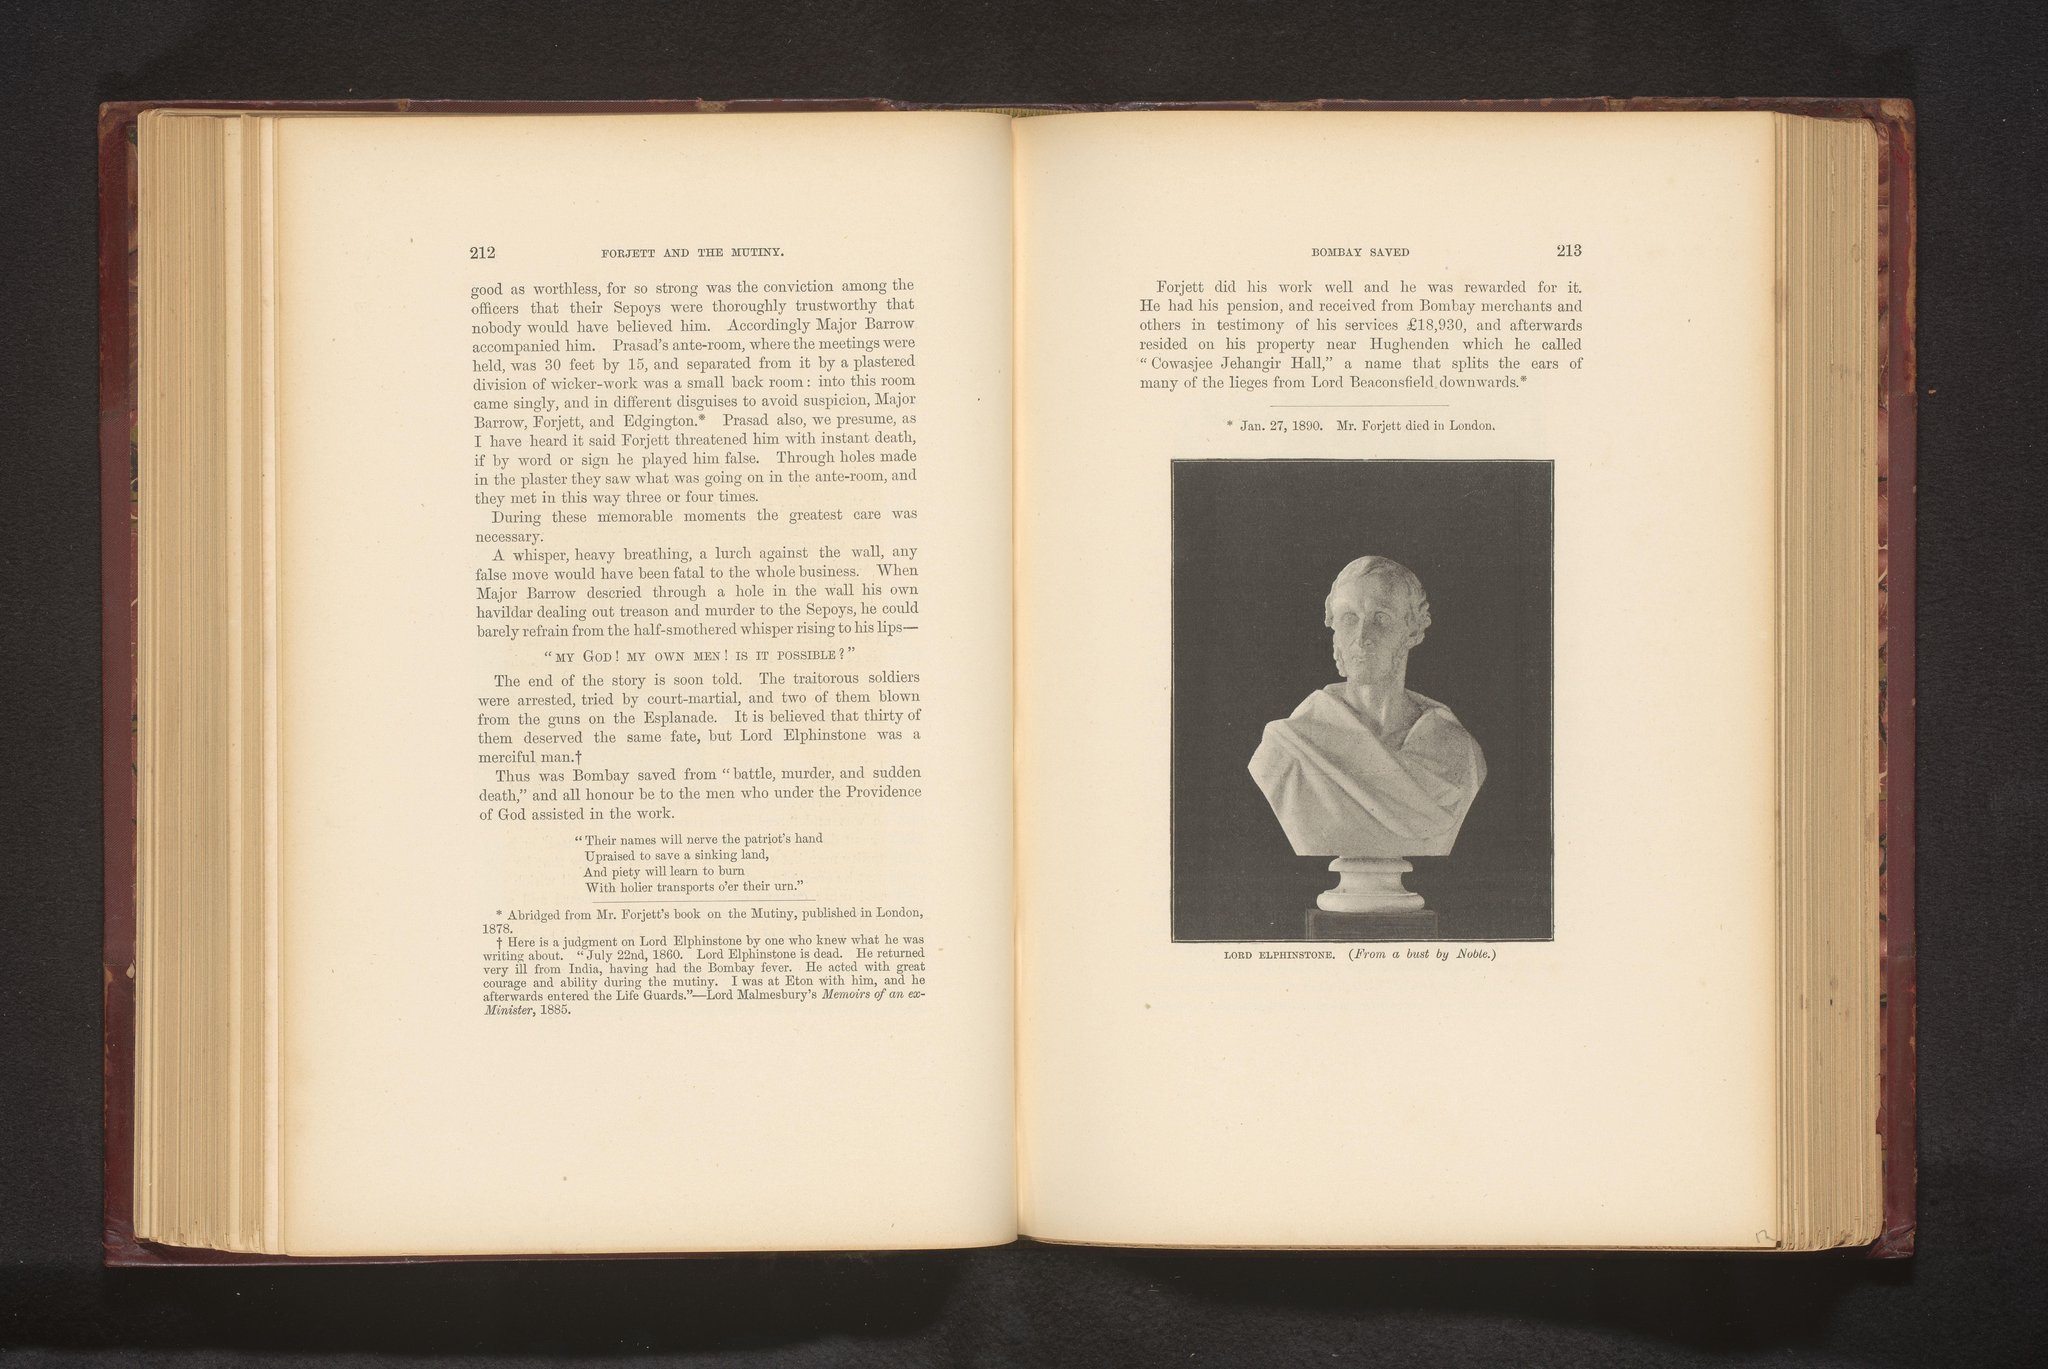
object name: page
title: Bust of Lord Elphinstone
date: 1883-1893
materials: paper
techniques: autotype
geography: paris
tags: chest, bust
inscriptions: caption: ‘LORD ELPHINSTONE. (From a bust by Noble.)’